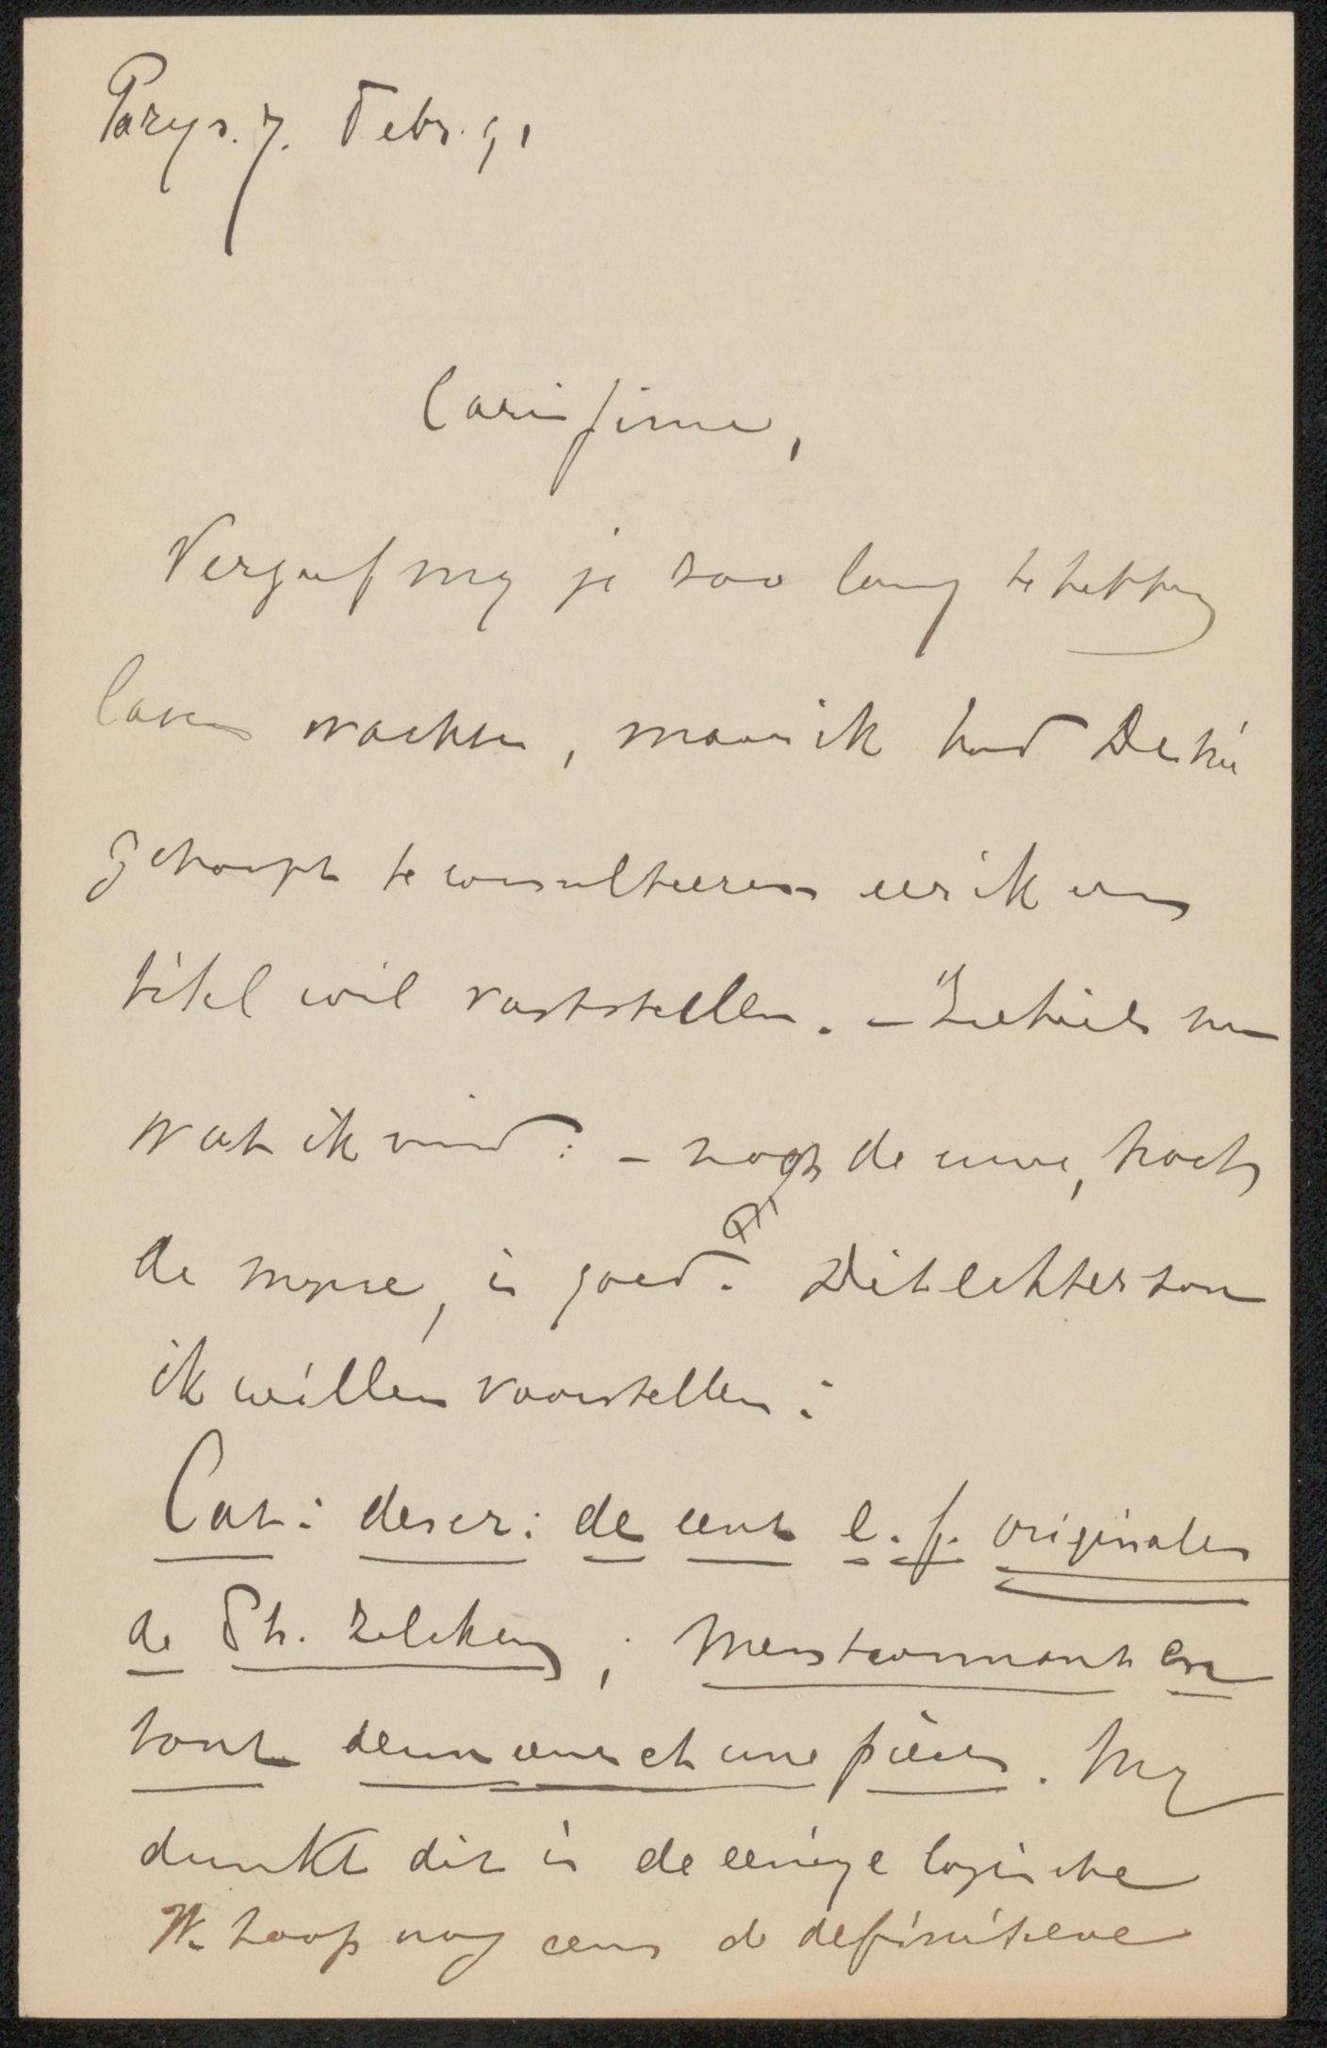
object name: letter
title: Brief aan Philip Zilcken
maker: adriaan pit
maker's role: print maker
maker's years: 1860-1944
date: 1891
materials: ink, paper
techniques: pen, writing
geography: paris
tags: martinus mouton, brussels, politician, jules destrée, the hague, painter, draughtsman, philip zilcken, printed matter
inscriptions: collector's mark: ‘RPK’, watermark